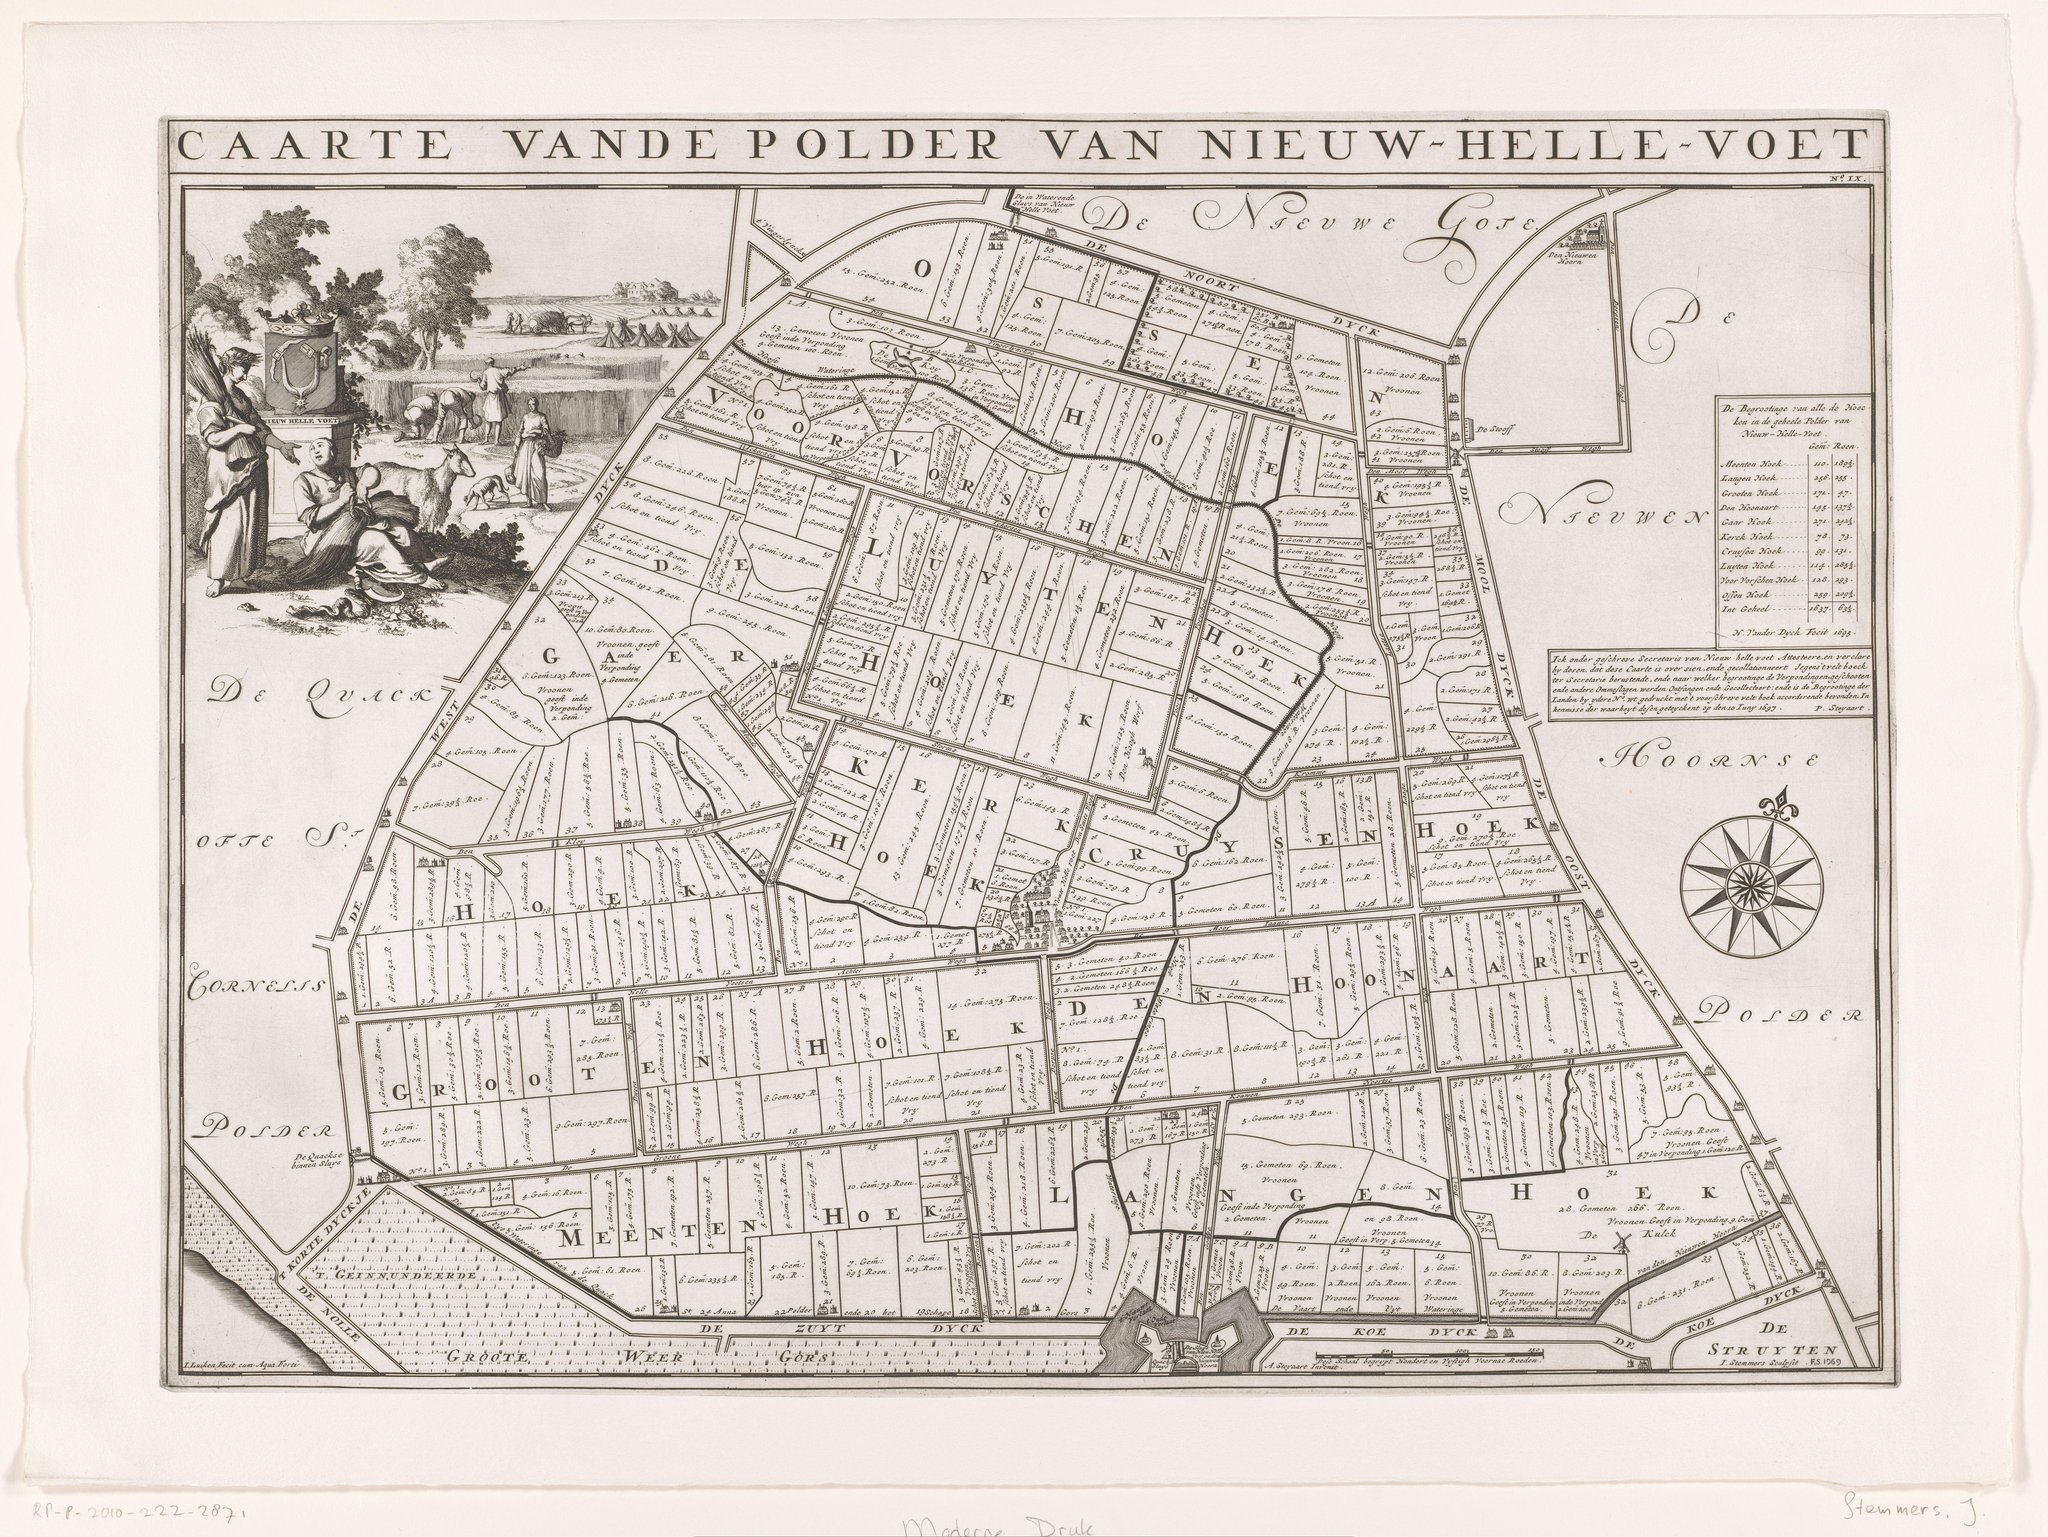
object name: print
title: Kaart van de polder Nieuw-Helvoet.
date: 1701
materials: paper, ink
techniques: engraving, etching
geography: amsterdam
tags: harvest, coat of arms (as symbol of the state, etc.), maps of separate countries or regions, polder, reclaimed land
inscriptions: inscription: ‘F.S. 1969’, inscription: ‘Shirley’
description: Oorspronkelijk uitgegeven als onderdeel van een atlas bevattende kaarten van Voorne, Goeree en het westelijke gedeelte van Overflakkee, getiteld 'Voorne. Caart-Boeck van alle de Dorpen, en Polders gelegen Inden Lande van Oost, ende West Voorne, Mitsgaders Over Flacqueê ... (1701). Auteurs: titelpagina "Rom. de Hooge I.U.D. et Com.R.Auct."; kaartbladen, opmeting "Heyman van (der) Dyck Fecit" (1695-1697), tekening "A. Steyaart Invenit", gravure "I. Stemmers Sculpsit" (na 1697), cartouche "I. Luiken Fecit cum Aqua Forti". Zie ook RP-P-AO-14-56C.